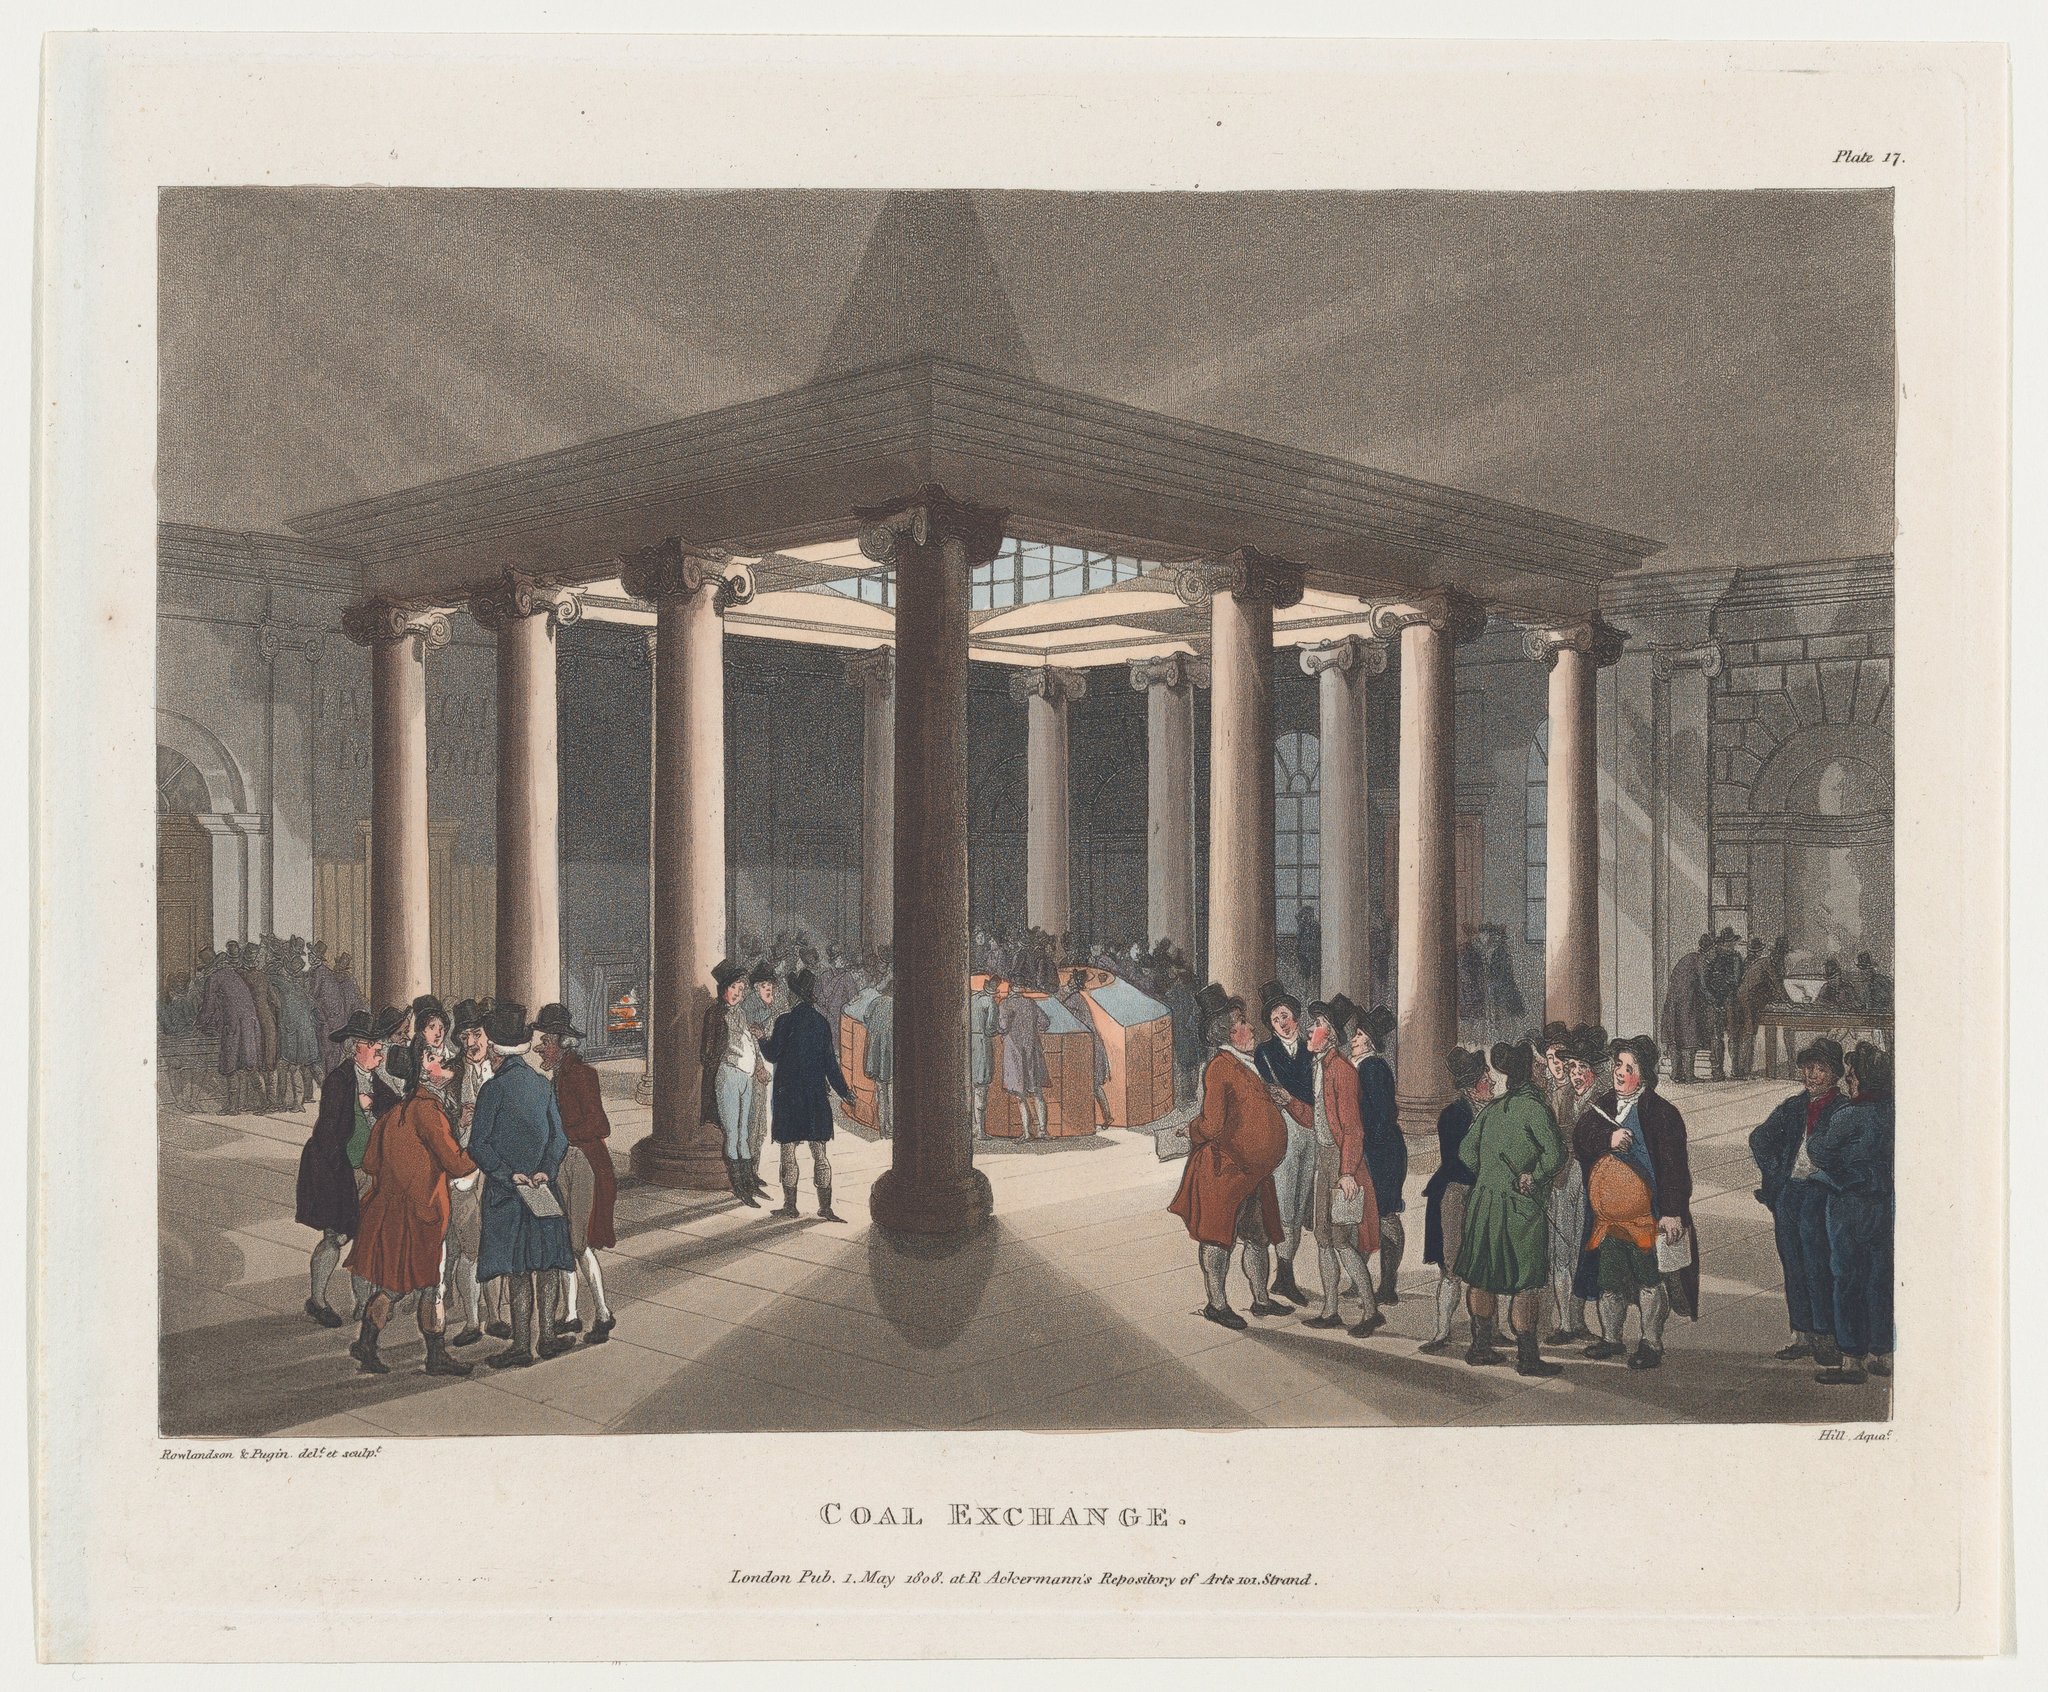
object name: print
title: Coal Exchange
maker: thomas rowlandson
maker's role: artist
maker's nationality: british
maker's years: 1757-1827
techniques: aquatint, etching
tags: columns,interiors,men,crowd